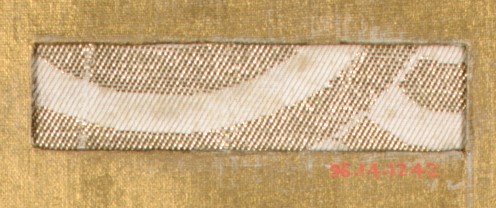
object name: piece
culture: japanese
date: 1701-1900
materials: silk